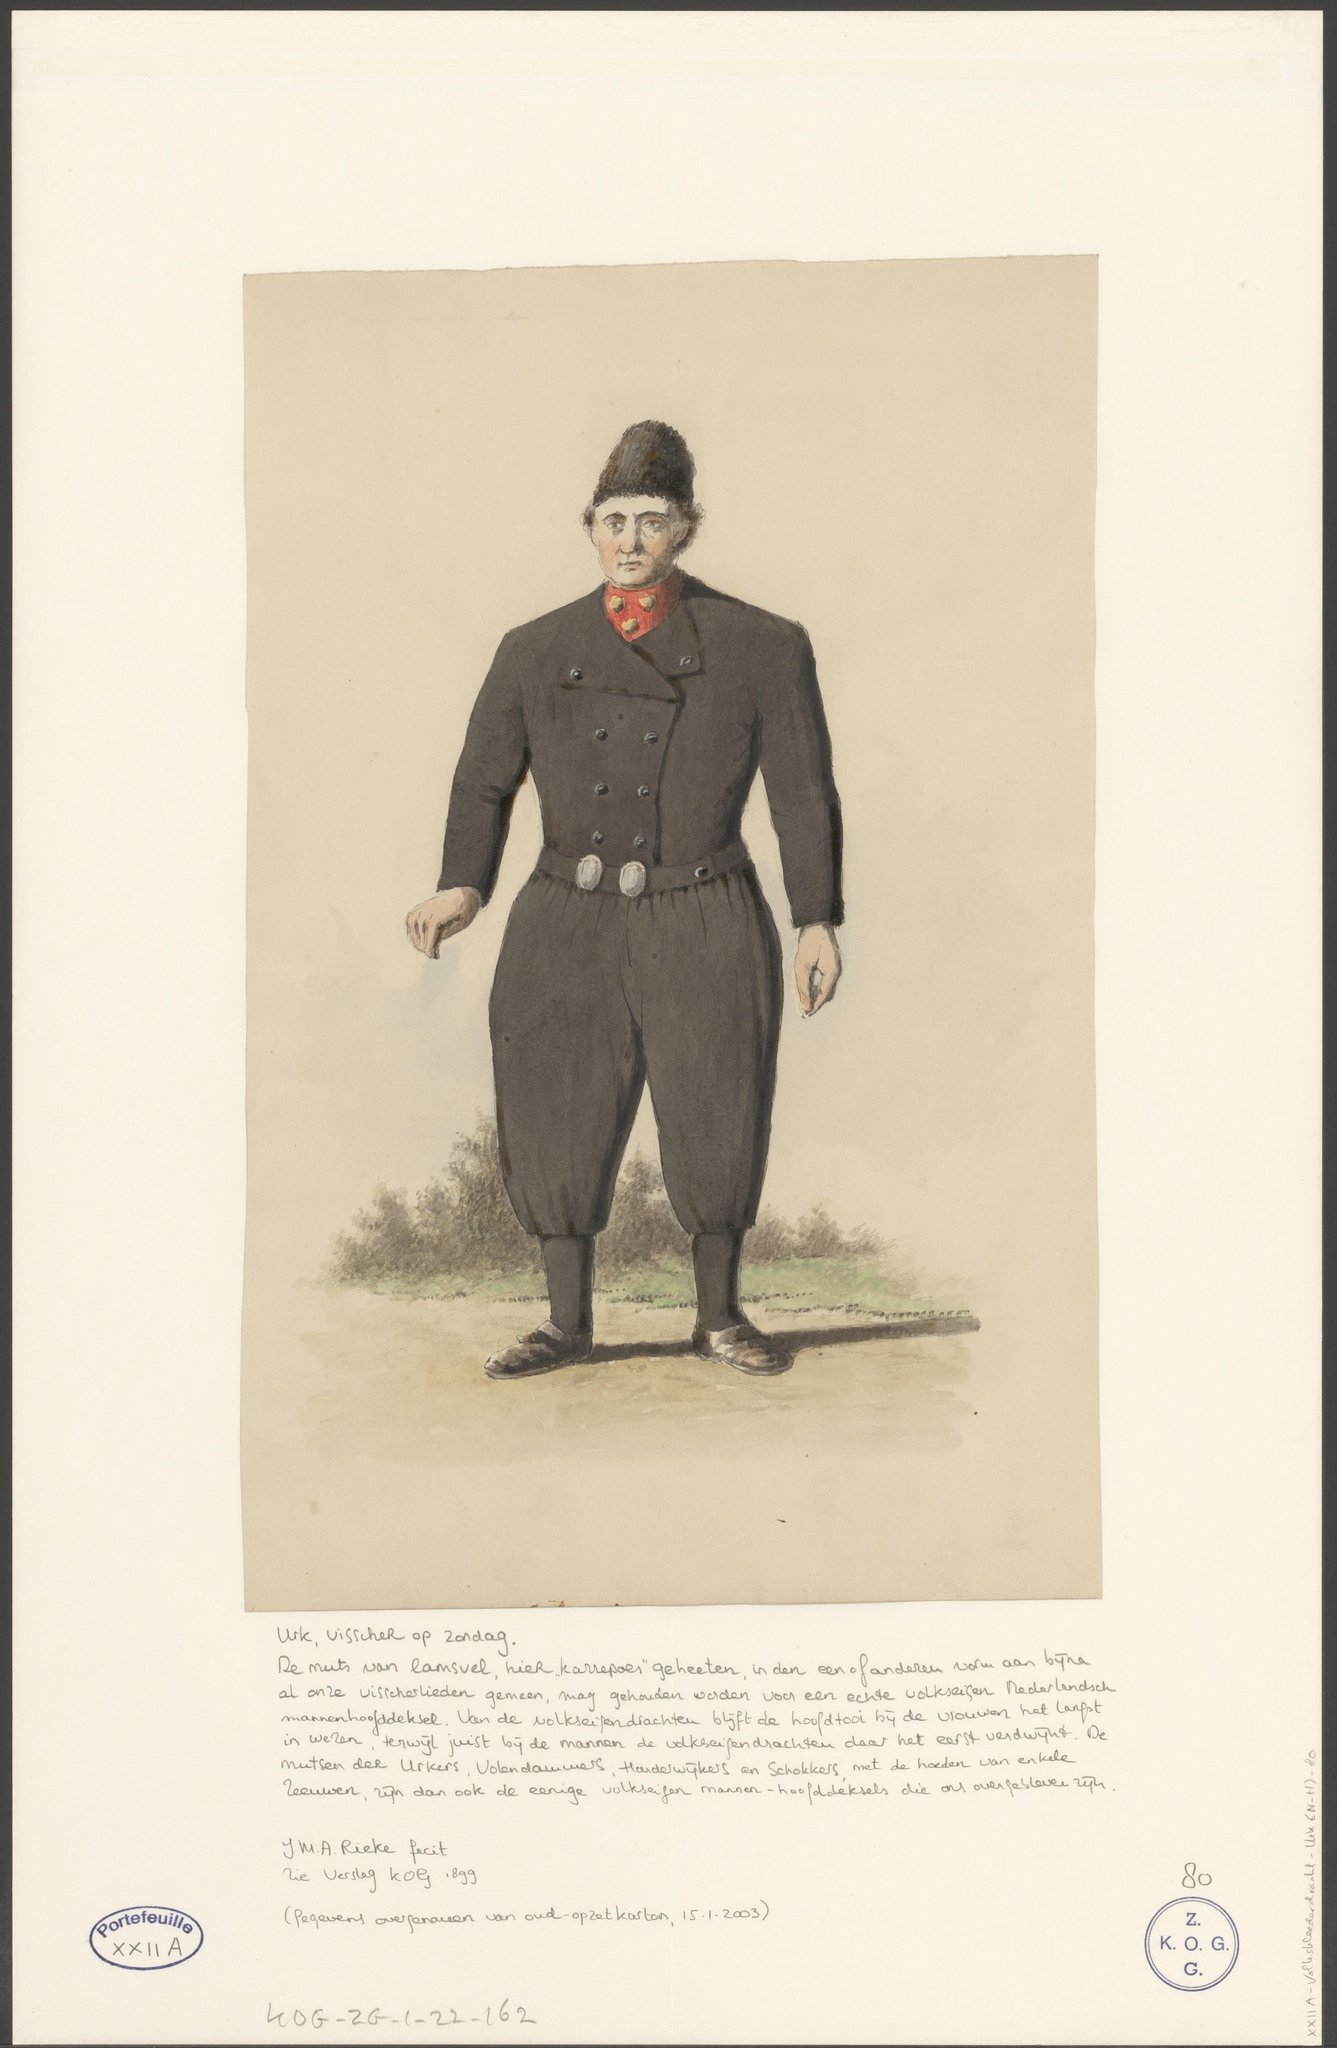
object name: drawing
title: Urk, visser op zondag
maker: johan martinus anthon rieke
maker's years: 1851-1899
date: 1896-1898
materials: paper, watercolor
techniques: brush, hand coloring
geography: netherlands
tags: sea and coastal fishery (+ men (labourers)), clothes, costume (+ men's clothes), folk costume, regional costume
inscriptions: collector's mark: Lugt 1641, collector's mark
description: Visser van Urk, in zondagse dracht. Tekening vervaardigd voor de tentoonstelling over Nederlandse klederdrachten gehouden in het Stedelijk Museum te Amsterdam in september 1898. Onderwerpsrubrieken binnen de Atlas Zeden en Gewoonten: De Kleeding, Volkskleederdracht, Noord-Holland.